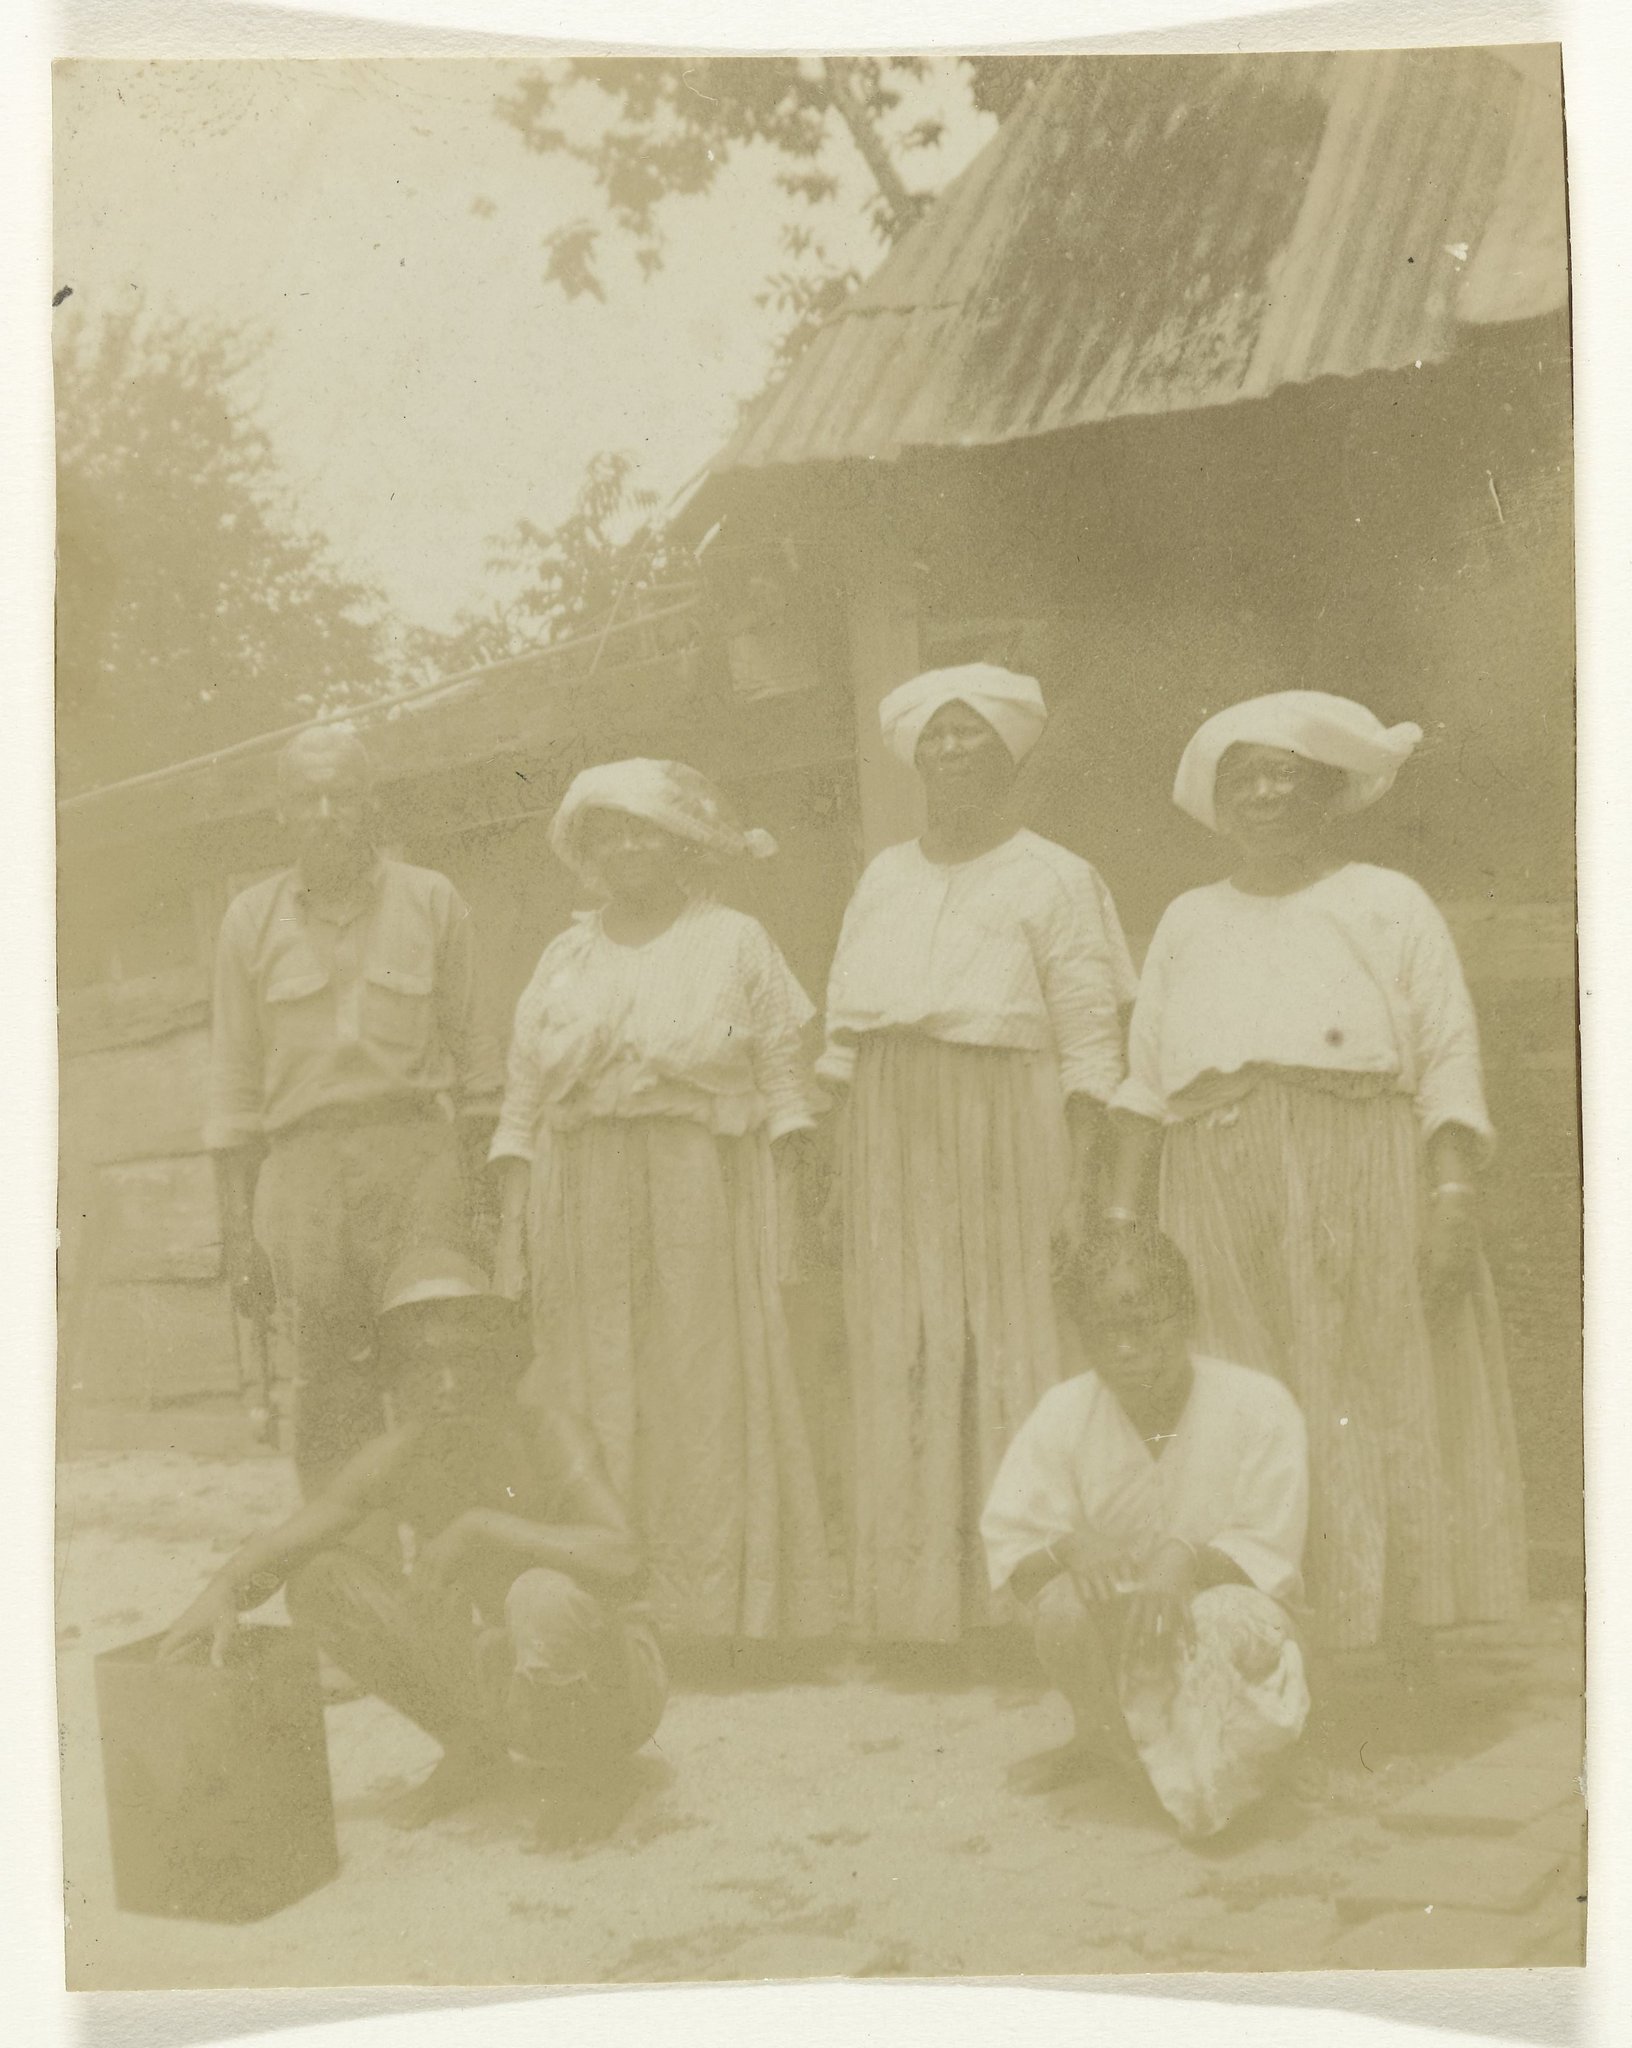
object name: photograph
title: Arbeiders op plantage Accaribo te Suriname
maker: theodoor brouwers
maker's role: amateurfotograaf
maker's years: 1874-1932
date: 1916-1930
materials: photographic support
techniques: photography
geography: suriname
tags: amsterdam, theodoor brouwers, plantation, suriname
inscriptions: inscription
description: In de periode 1911-1932 woonde op plantage Accaribo in Suriname de familie Brouwers van wie de foto's afkomstig zijn. Rond 1910 vond Theodoor Brouwers werk op plantage Accaribo. In 1929 werd hij eigenaar van de plantage.